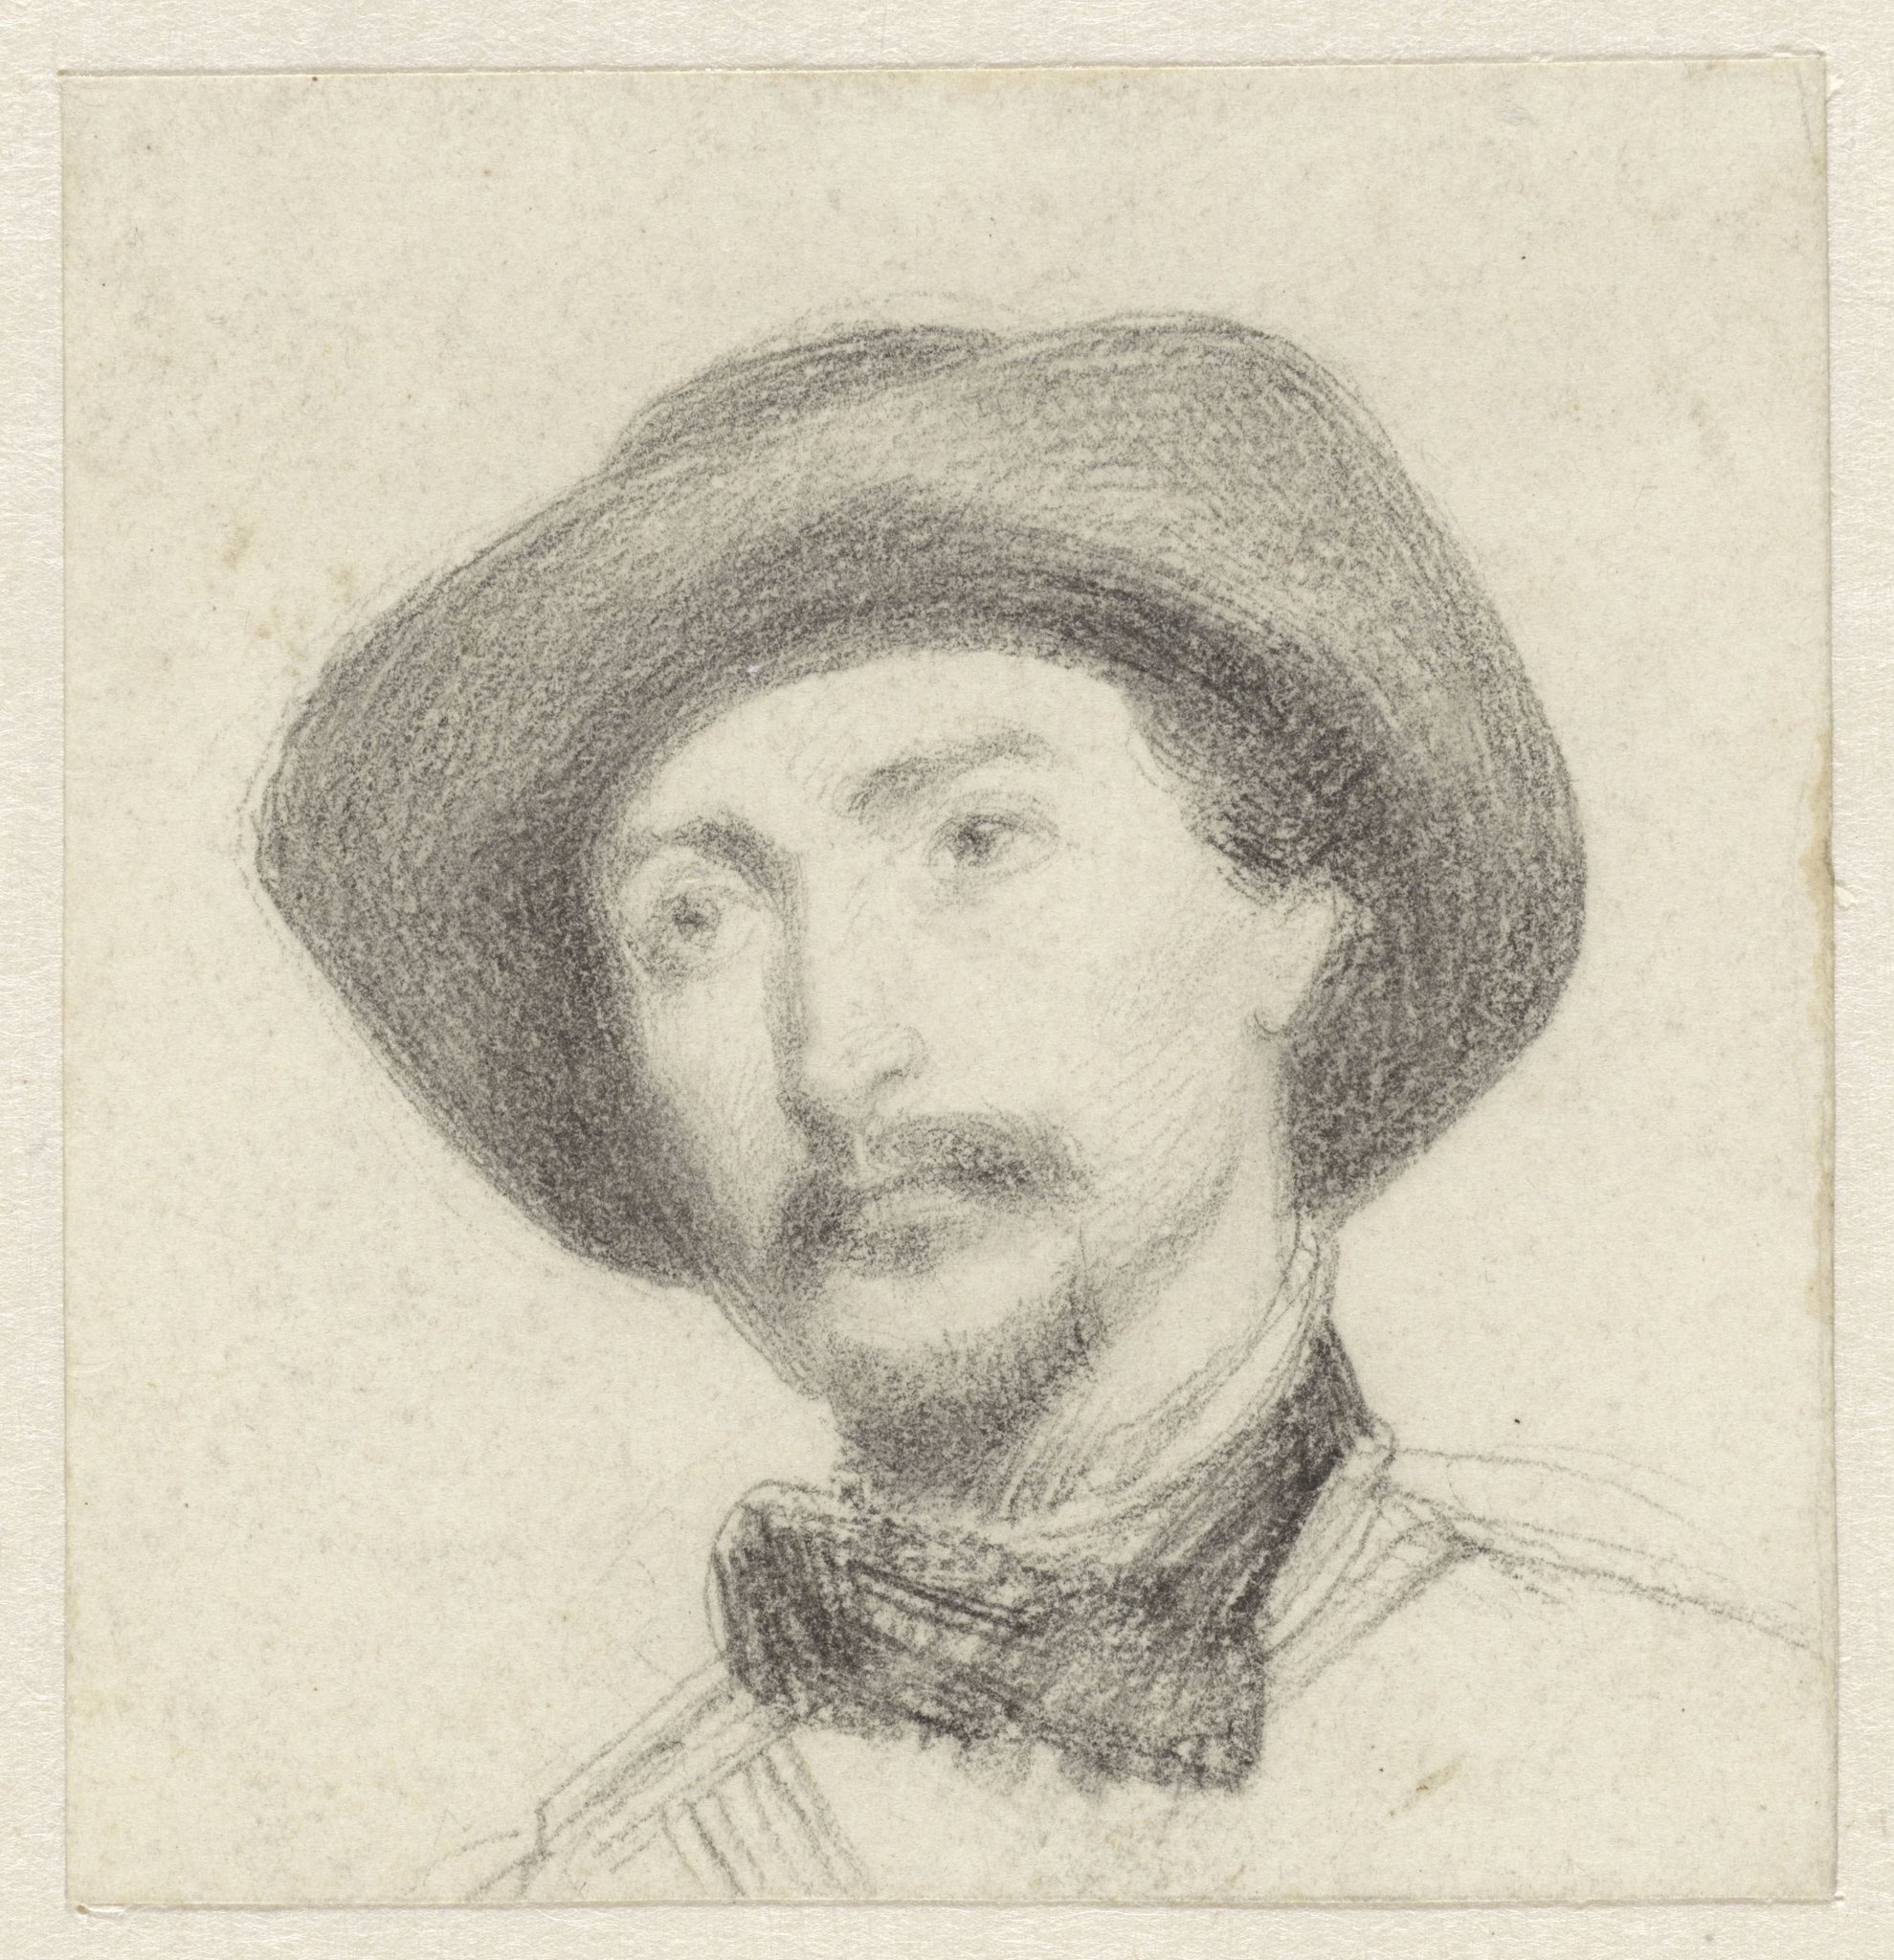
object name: drawing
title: Portret van een man, buste, met breedgerande hoed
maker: johann wilhelm friedrich kachel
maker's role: draughtsman, print maker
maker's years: 1826-1873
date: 1836-1873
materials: chalk, paper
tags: anonymous historical person portrayed alone